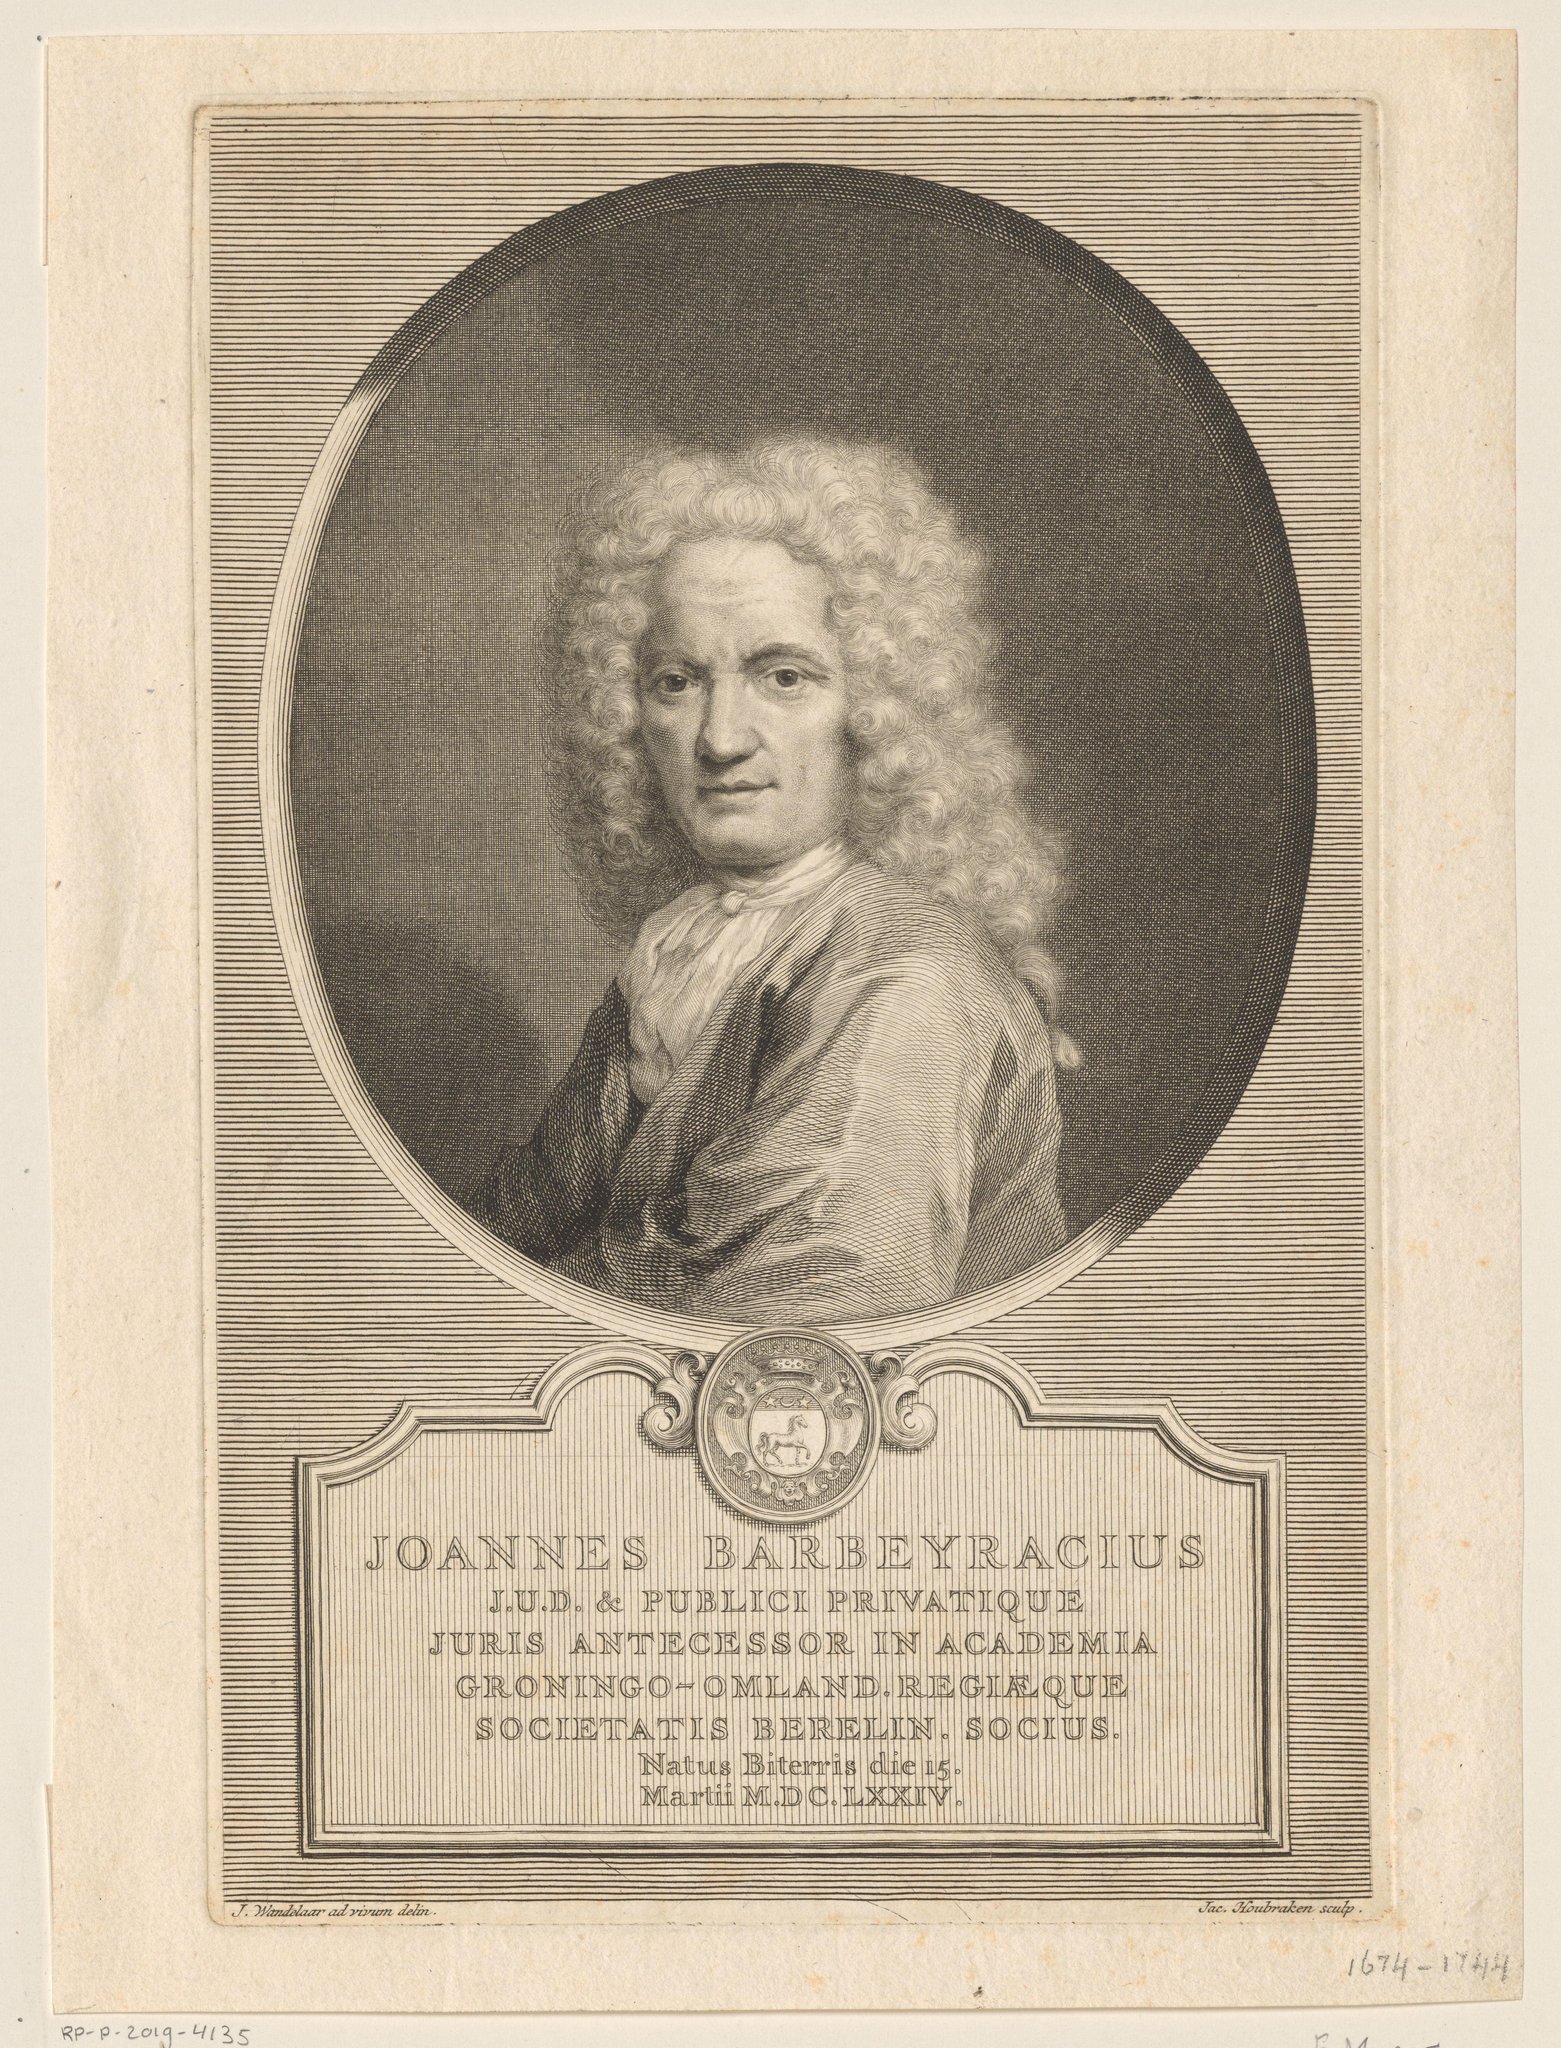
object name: print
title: Portret van Jean Barbeyrac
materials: paper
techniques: engraving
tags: historical persons, armorial bearing, heraldry